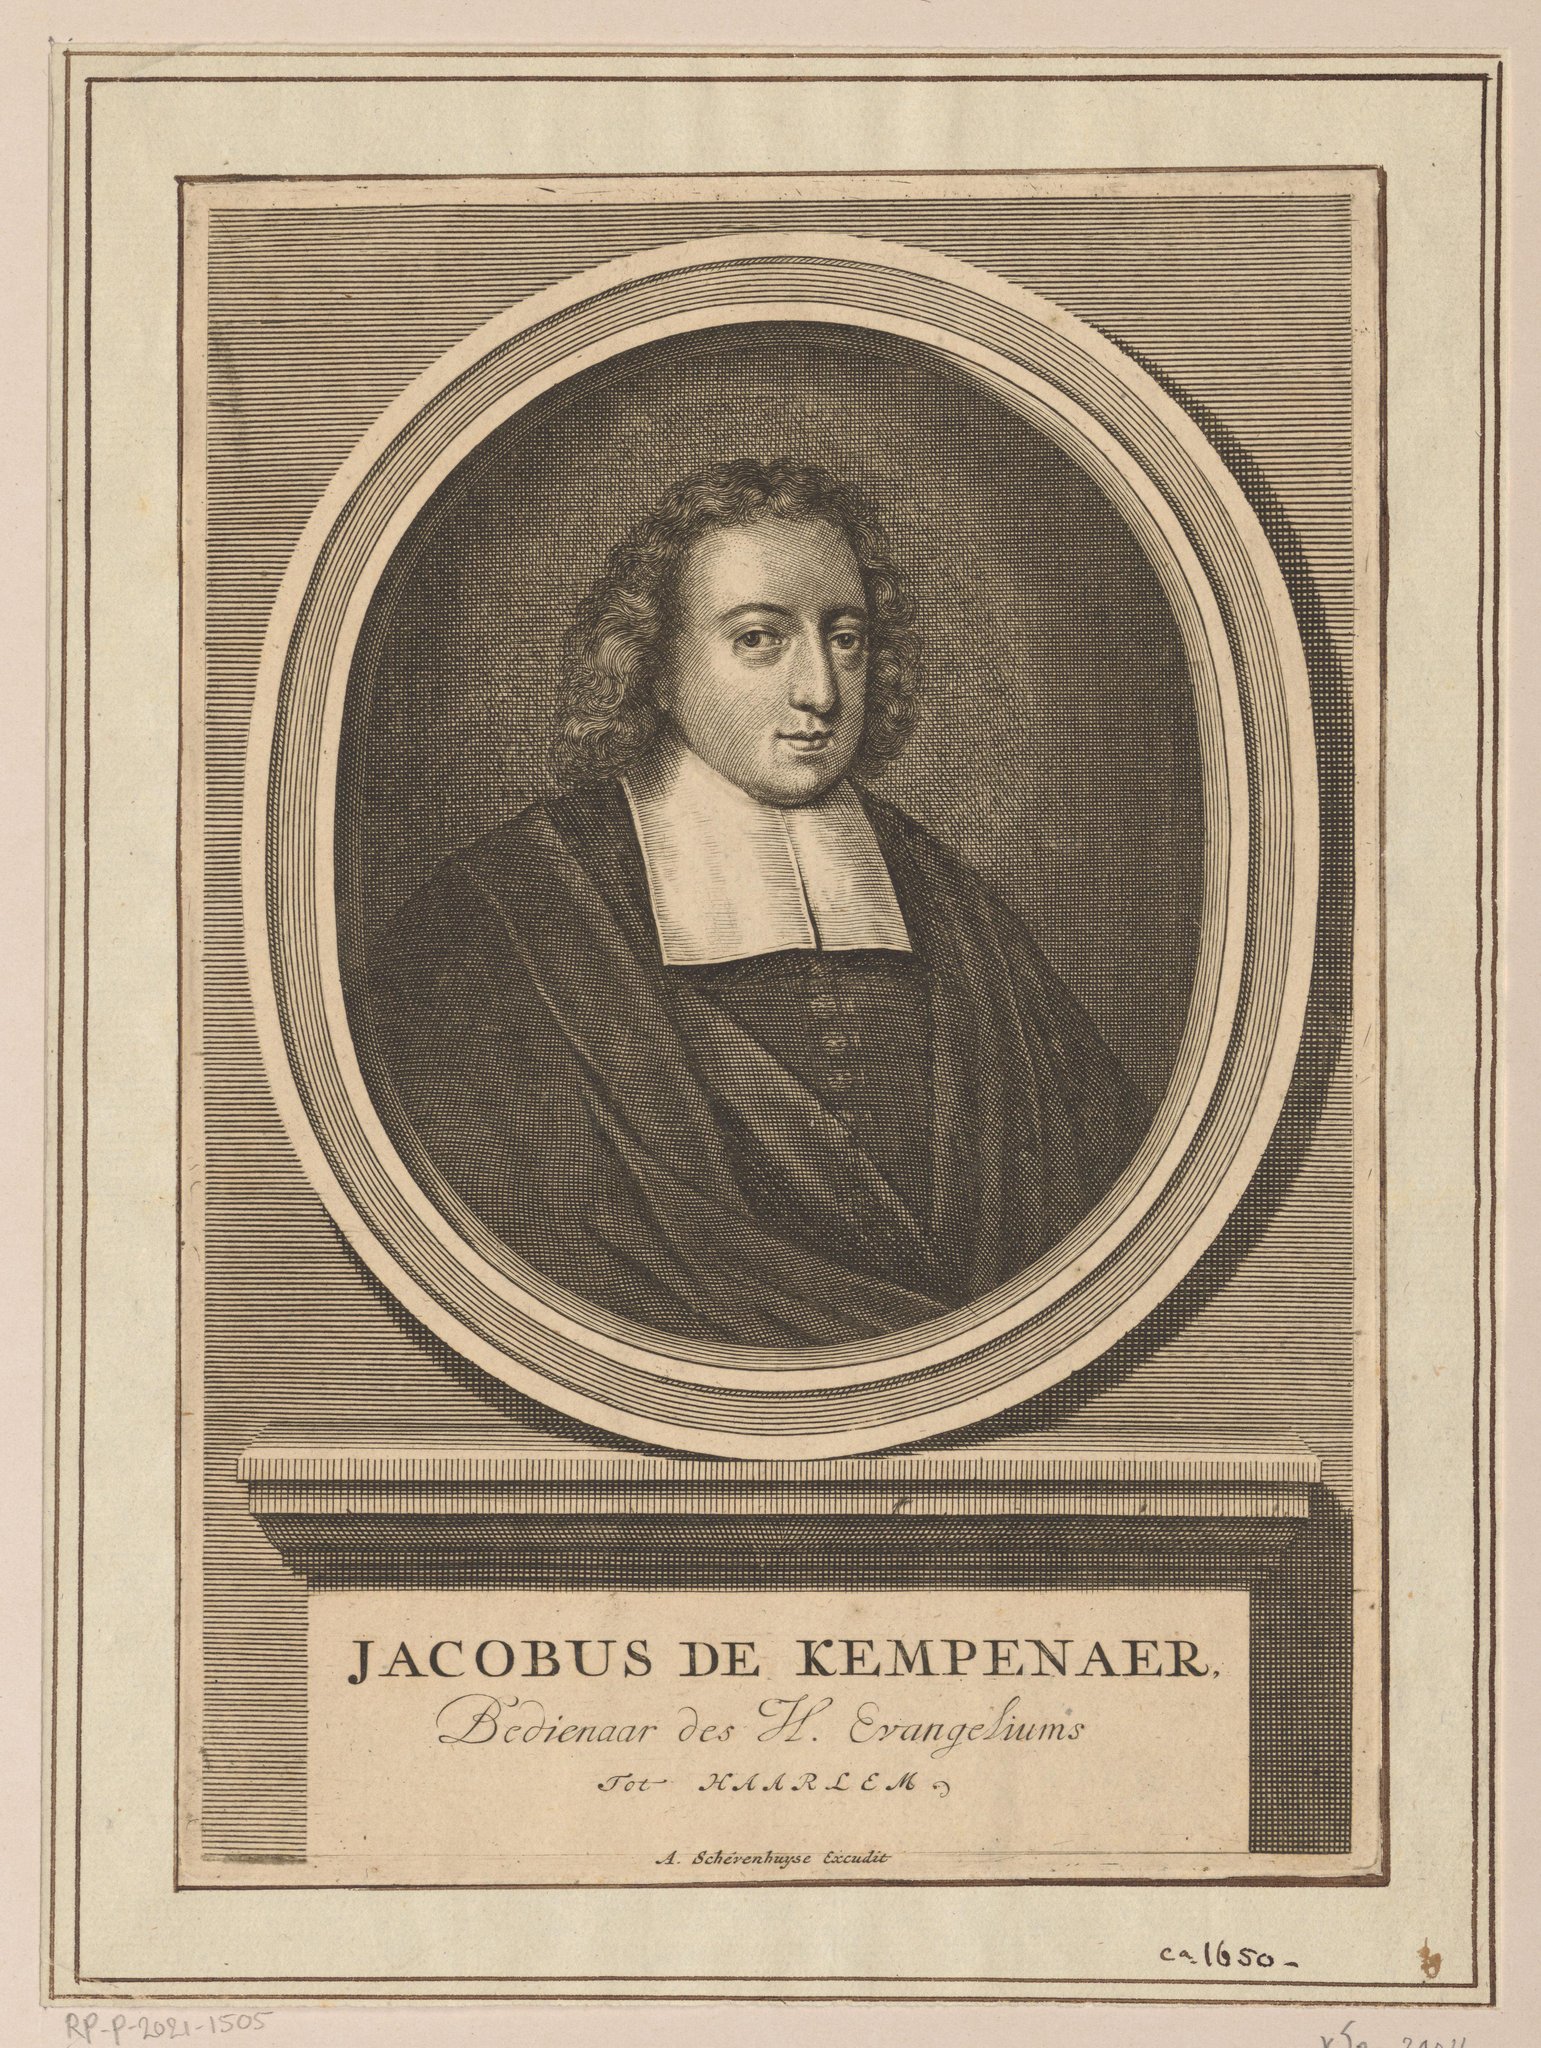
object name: print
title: Portret van Jacobus de Kempenaer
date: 1693-1712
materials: paper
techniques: engraving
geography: haarlem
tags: historical persons